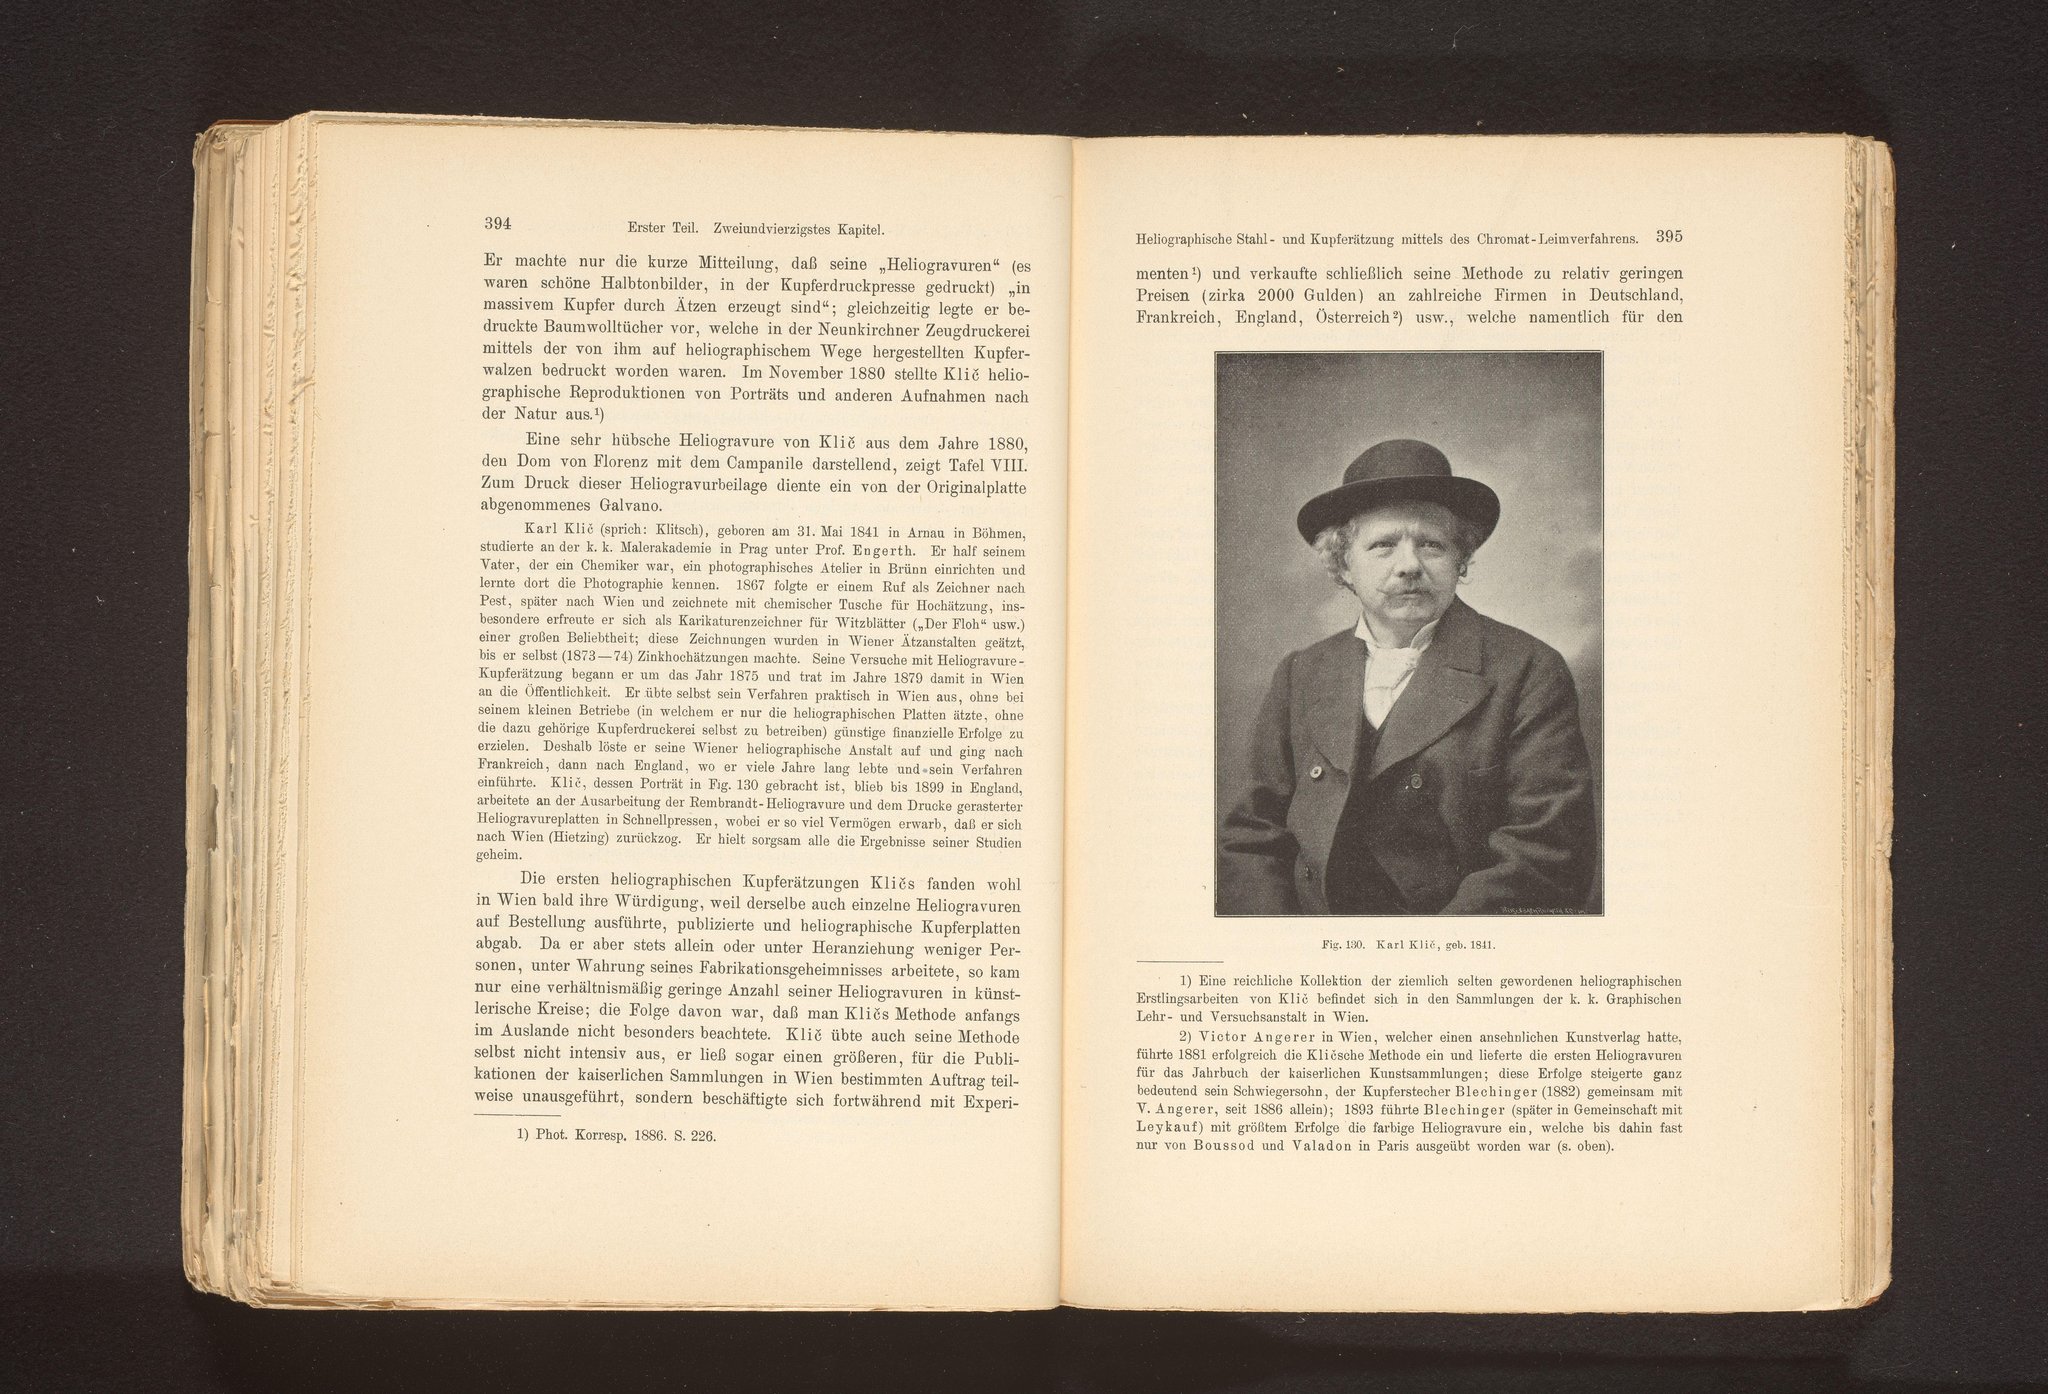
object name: page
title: Karl Klíč, geb. 1841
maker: Anonymous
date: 1900-1905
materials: paper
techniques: autotype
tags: karel klíč, portrait, self-portrait of photographer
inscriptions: number: ‘Fig. 130.’